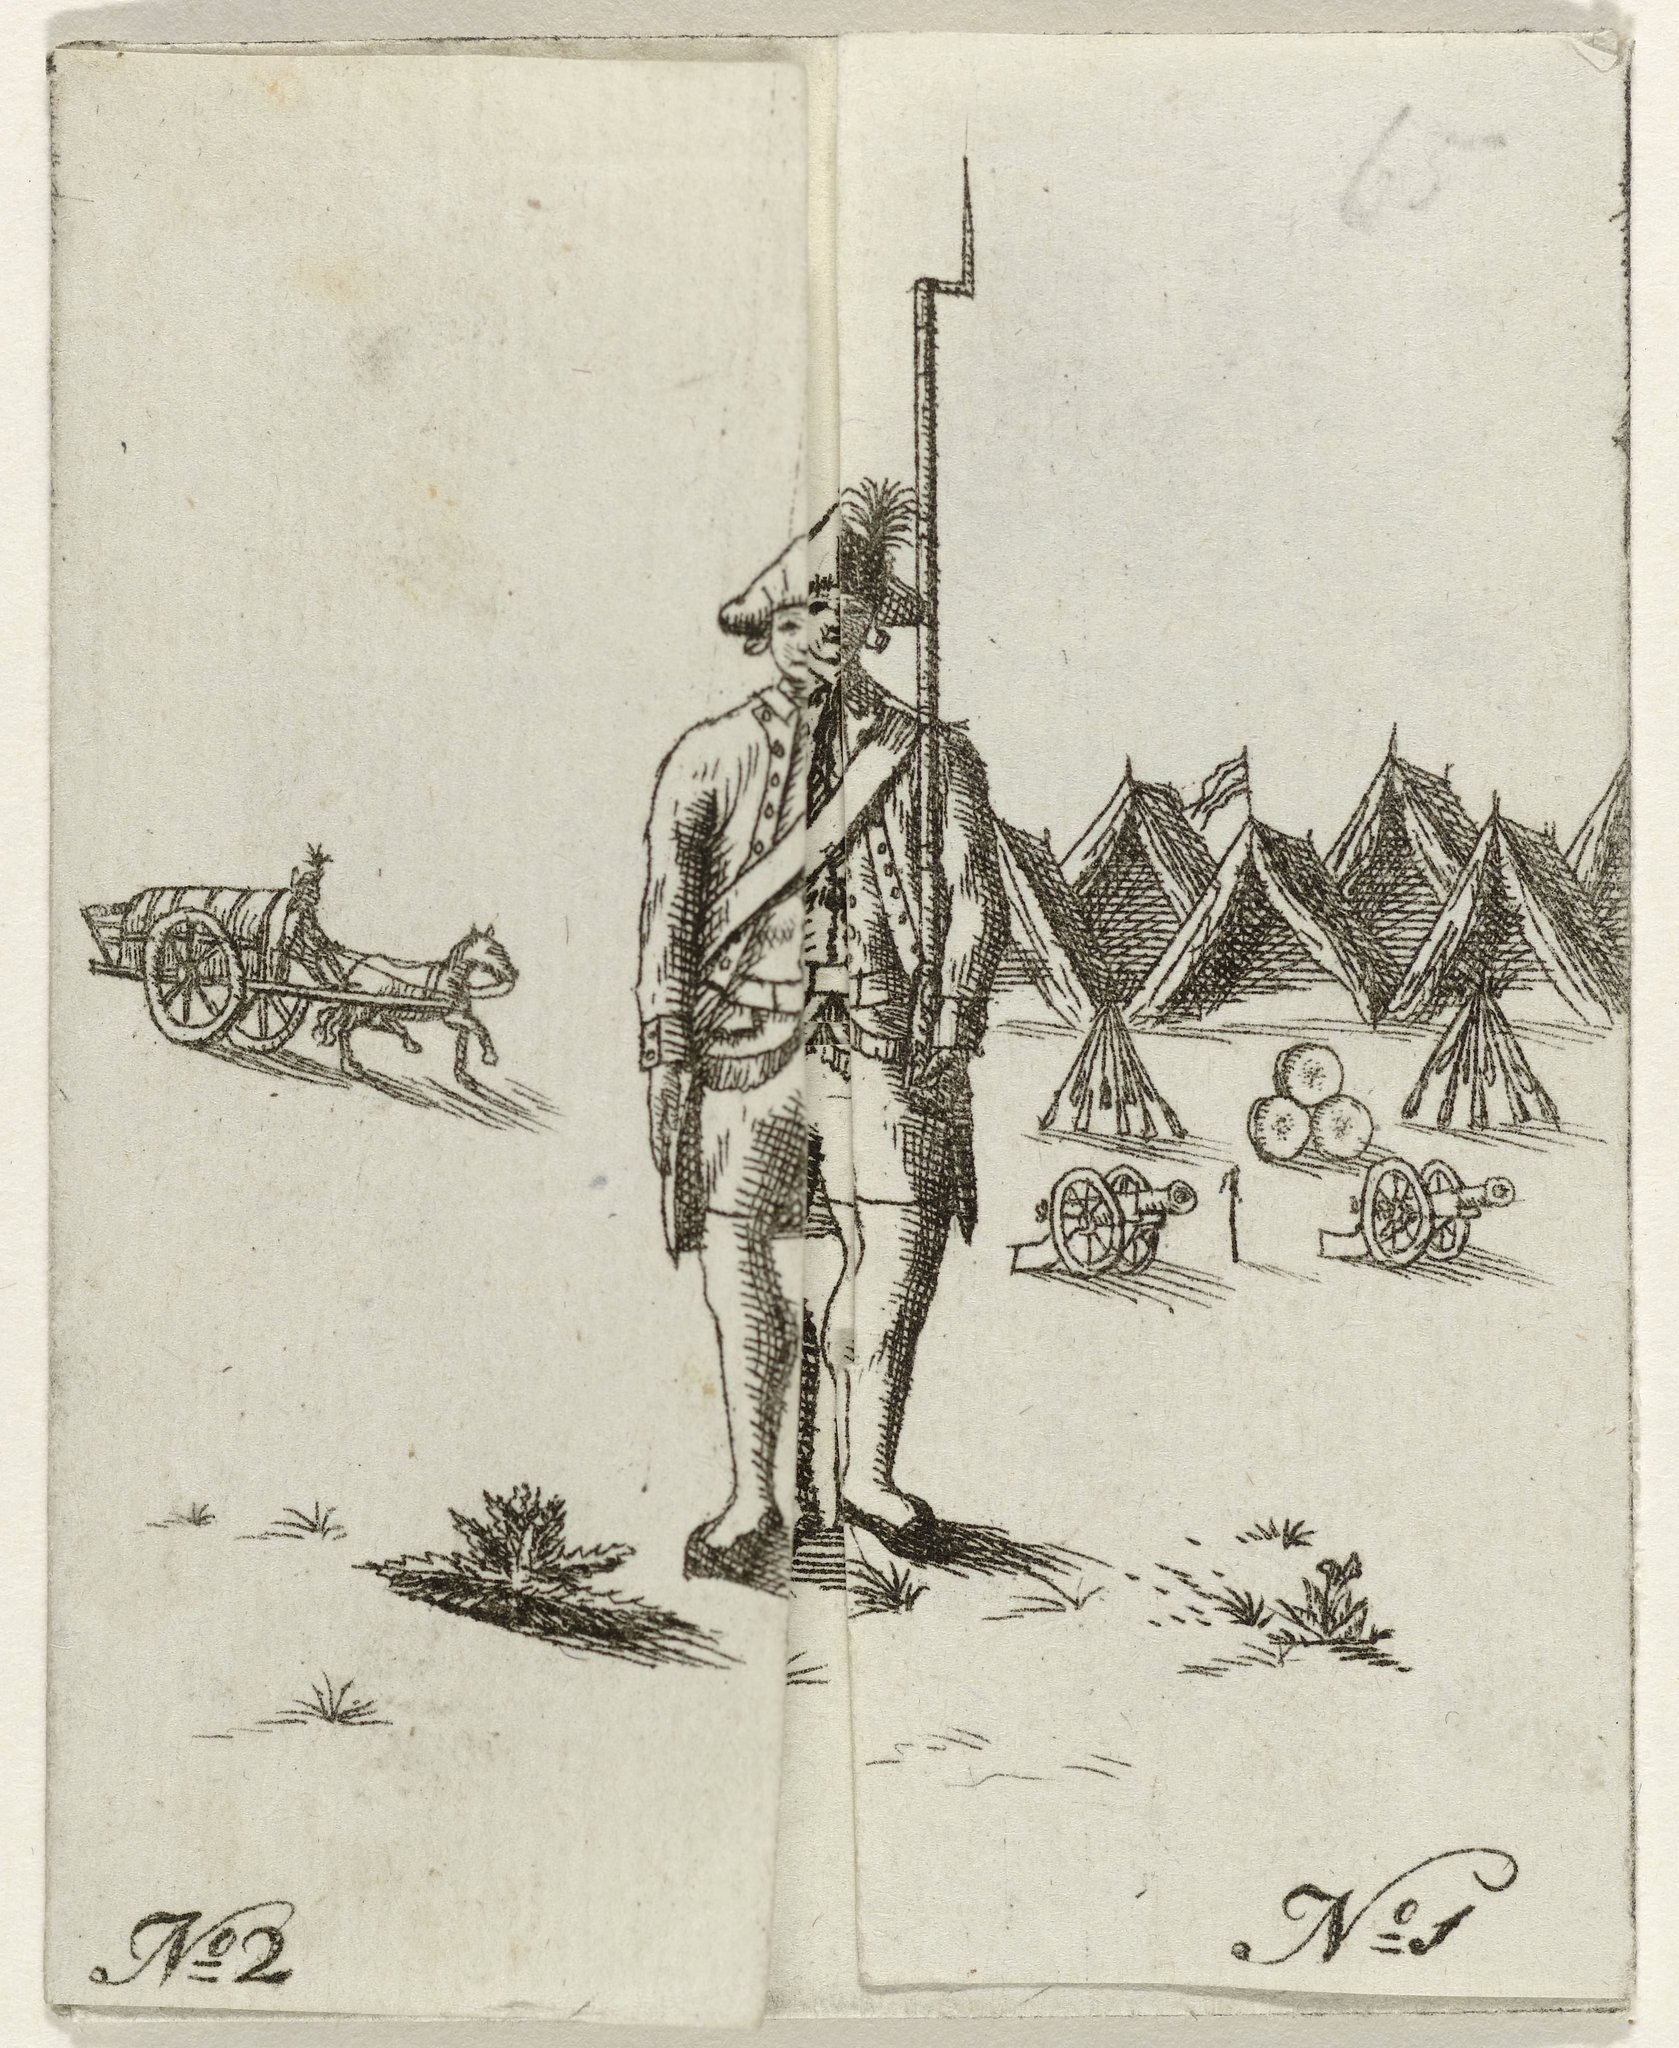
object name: print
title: Openslaande spotprent op een vrijkorpist van het Vliegend Legertje, 1787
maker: Anonymous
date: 1787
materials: paper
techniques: engraving, etching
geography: northern netherlands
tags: warfare; military affairs (+ citizen soldiery, civil guard, citizen militia), patriots (1780-1795)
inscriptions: collector's mark: Lugt 2228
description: Spotprent op een vrijkorpist van het Vliegend Legertje, 1787. Vouwprent waarvan vier flappen opengevouwen kunnen worden. De laatste - binnenste - voorstelling is een doorkijkprent of transparant waarin de patriot staande bij een galg getroffen wordt door bliksem uit de hemel. De flappen en voorstellingen genummerd 1-6. Bij de prent behoort een verklaring.